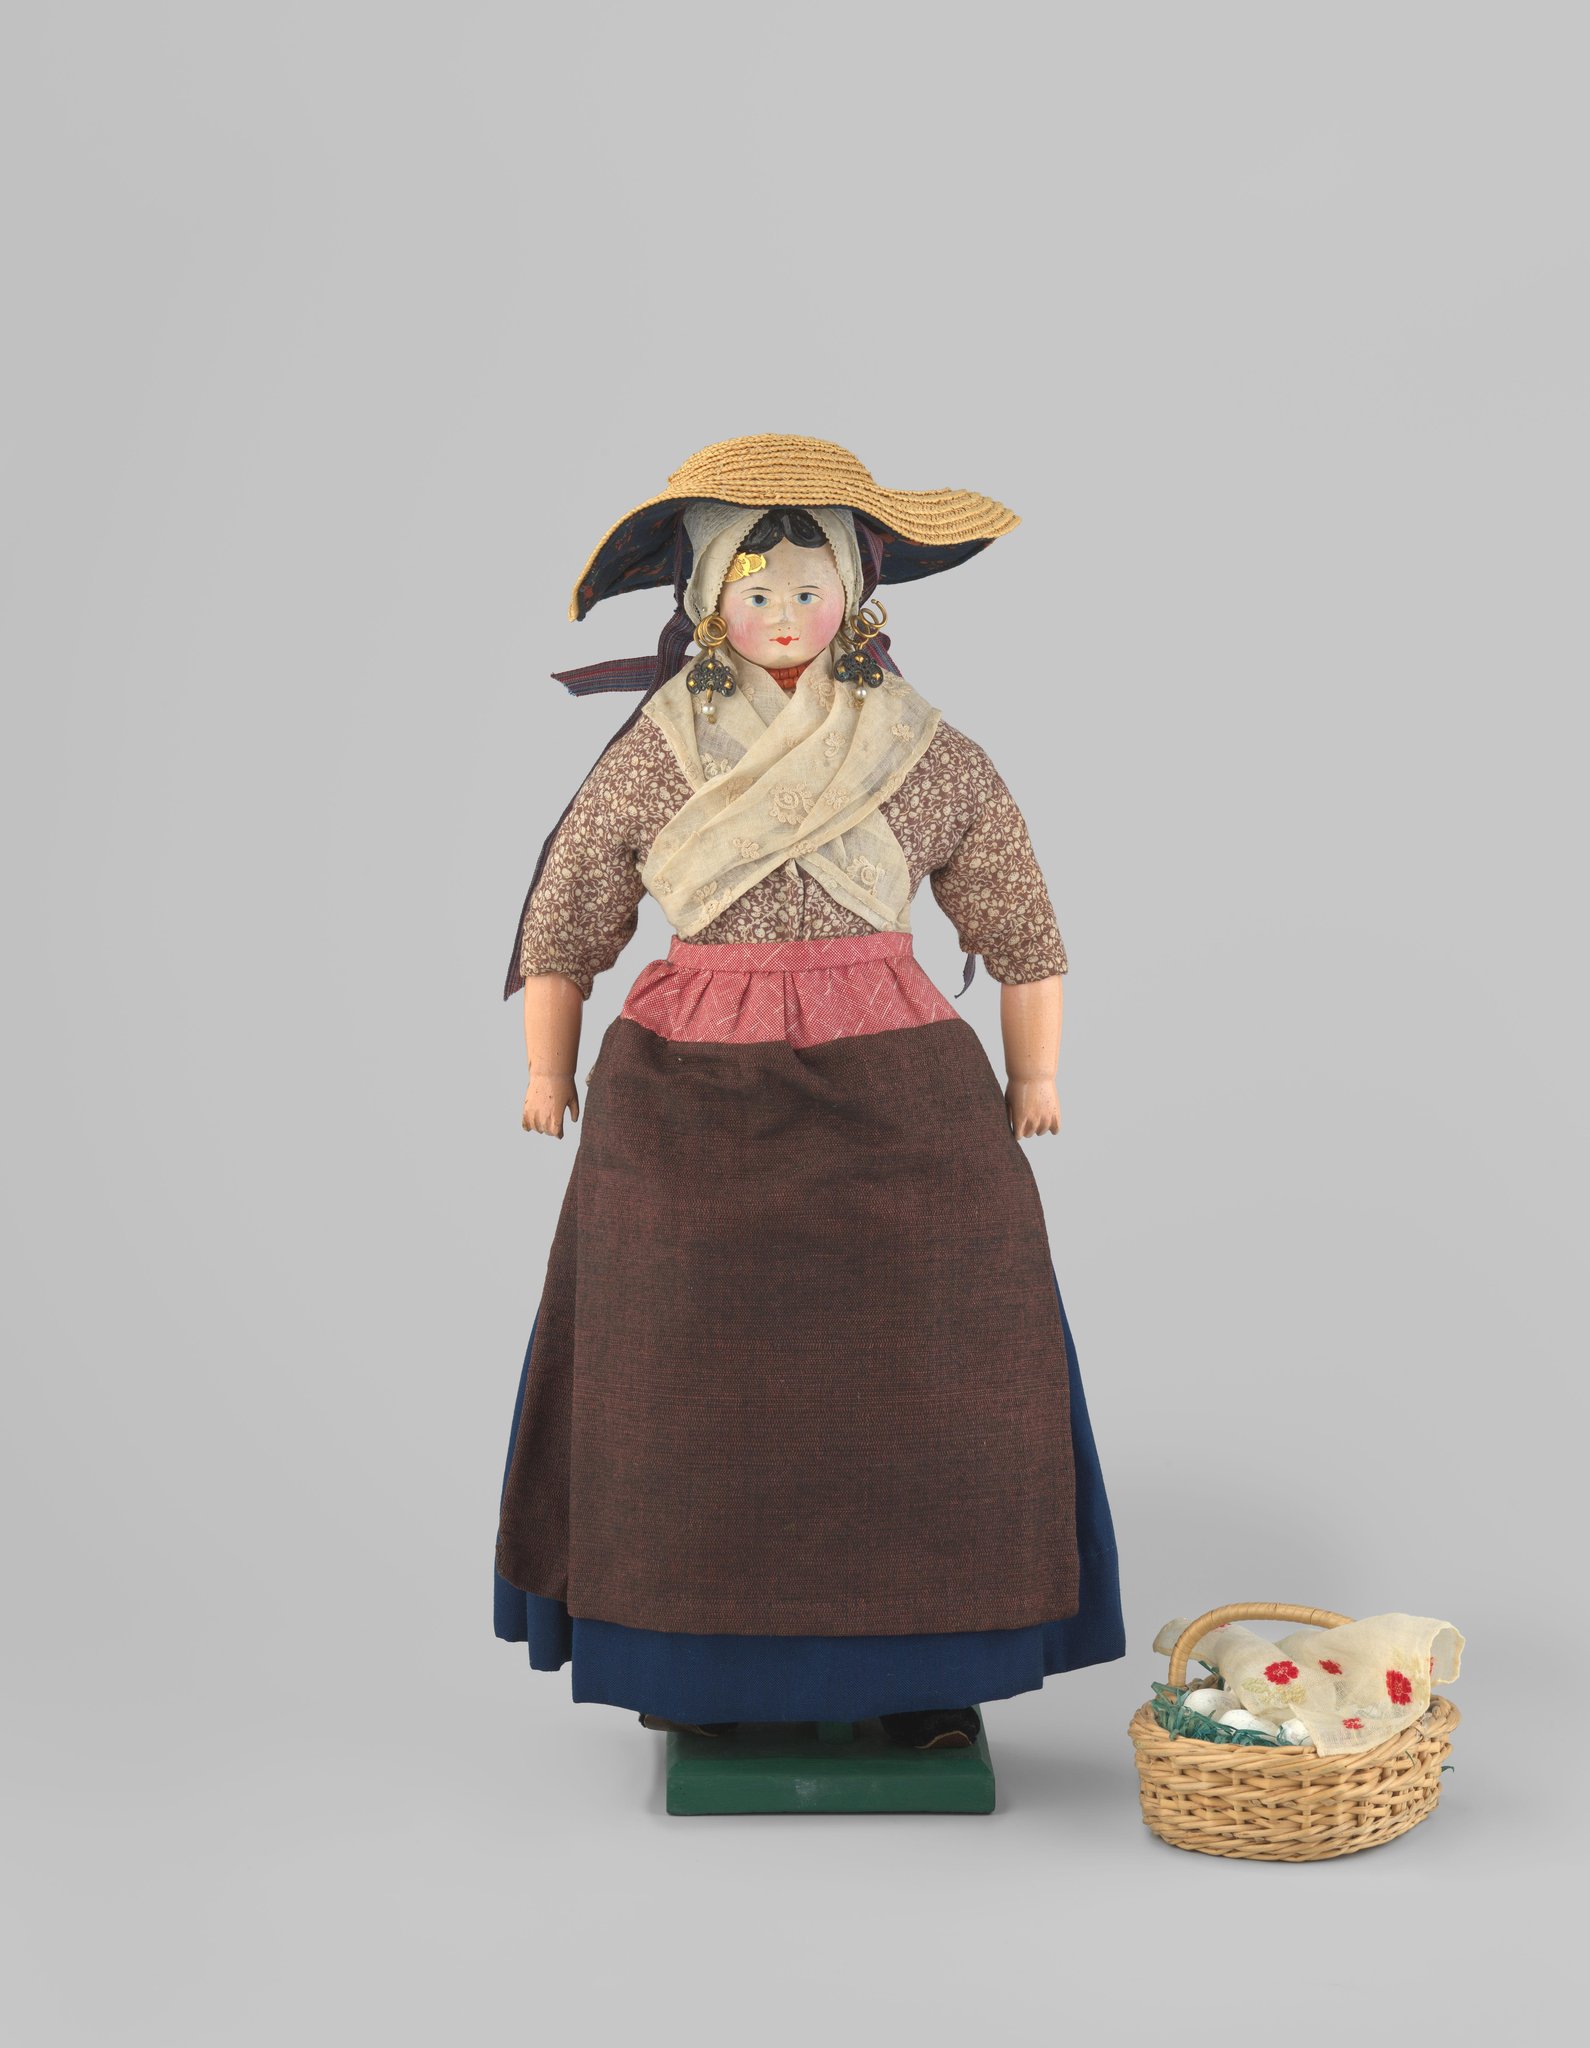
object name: regional dress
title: Pop in boerinnendracht van Walcheren van 1813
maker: Anonymous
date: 1913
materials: textile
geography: netherlands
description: Pop in boerinnendracht van Walcheren van 1813. Met kap en strooien hoed, paars jak, blauwe rok, rood schort, bloedkoralen collier.